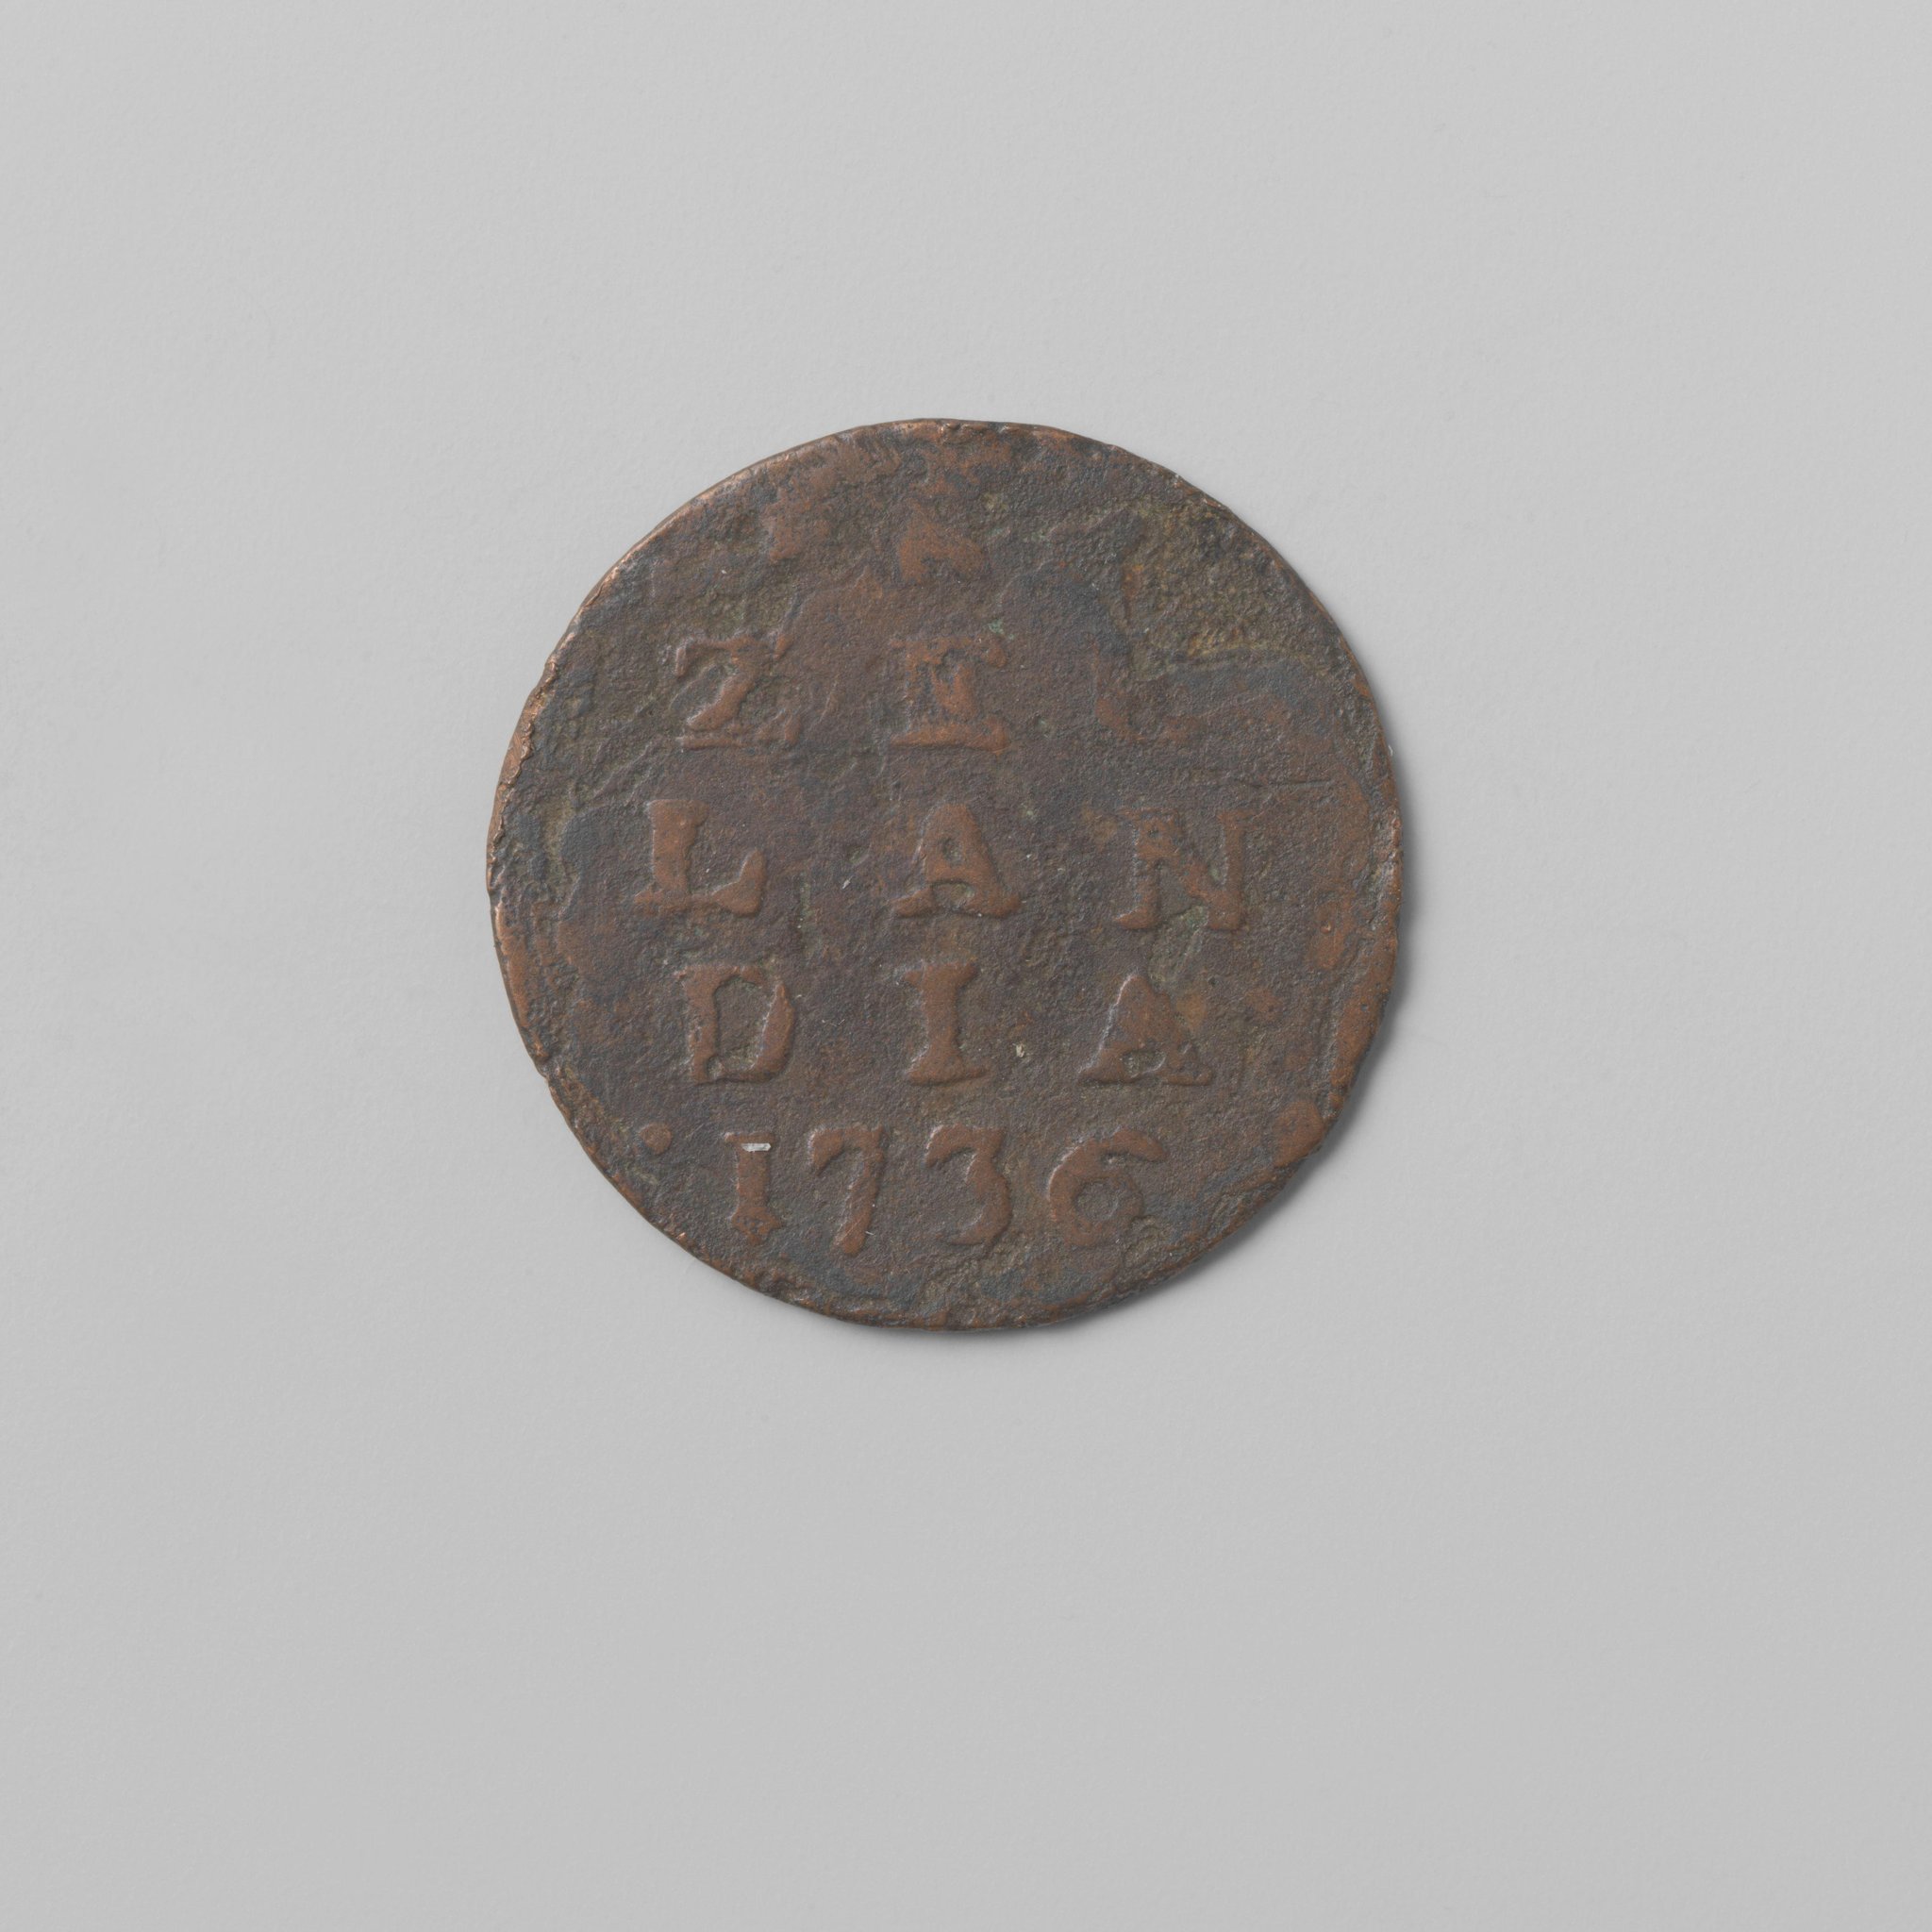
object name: coin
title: Zeeuwse duit, 1736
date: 1736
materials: copper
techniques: striking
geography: middelburg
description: Koperen munt. Voorzijde: gekroond, zijdelings ingedeukt wapenschild van Zeeland. Keerzijde: opschrift in drie regels, waarboven muntteken burcht tussen twee sterren en waaronder jaartal..